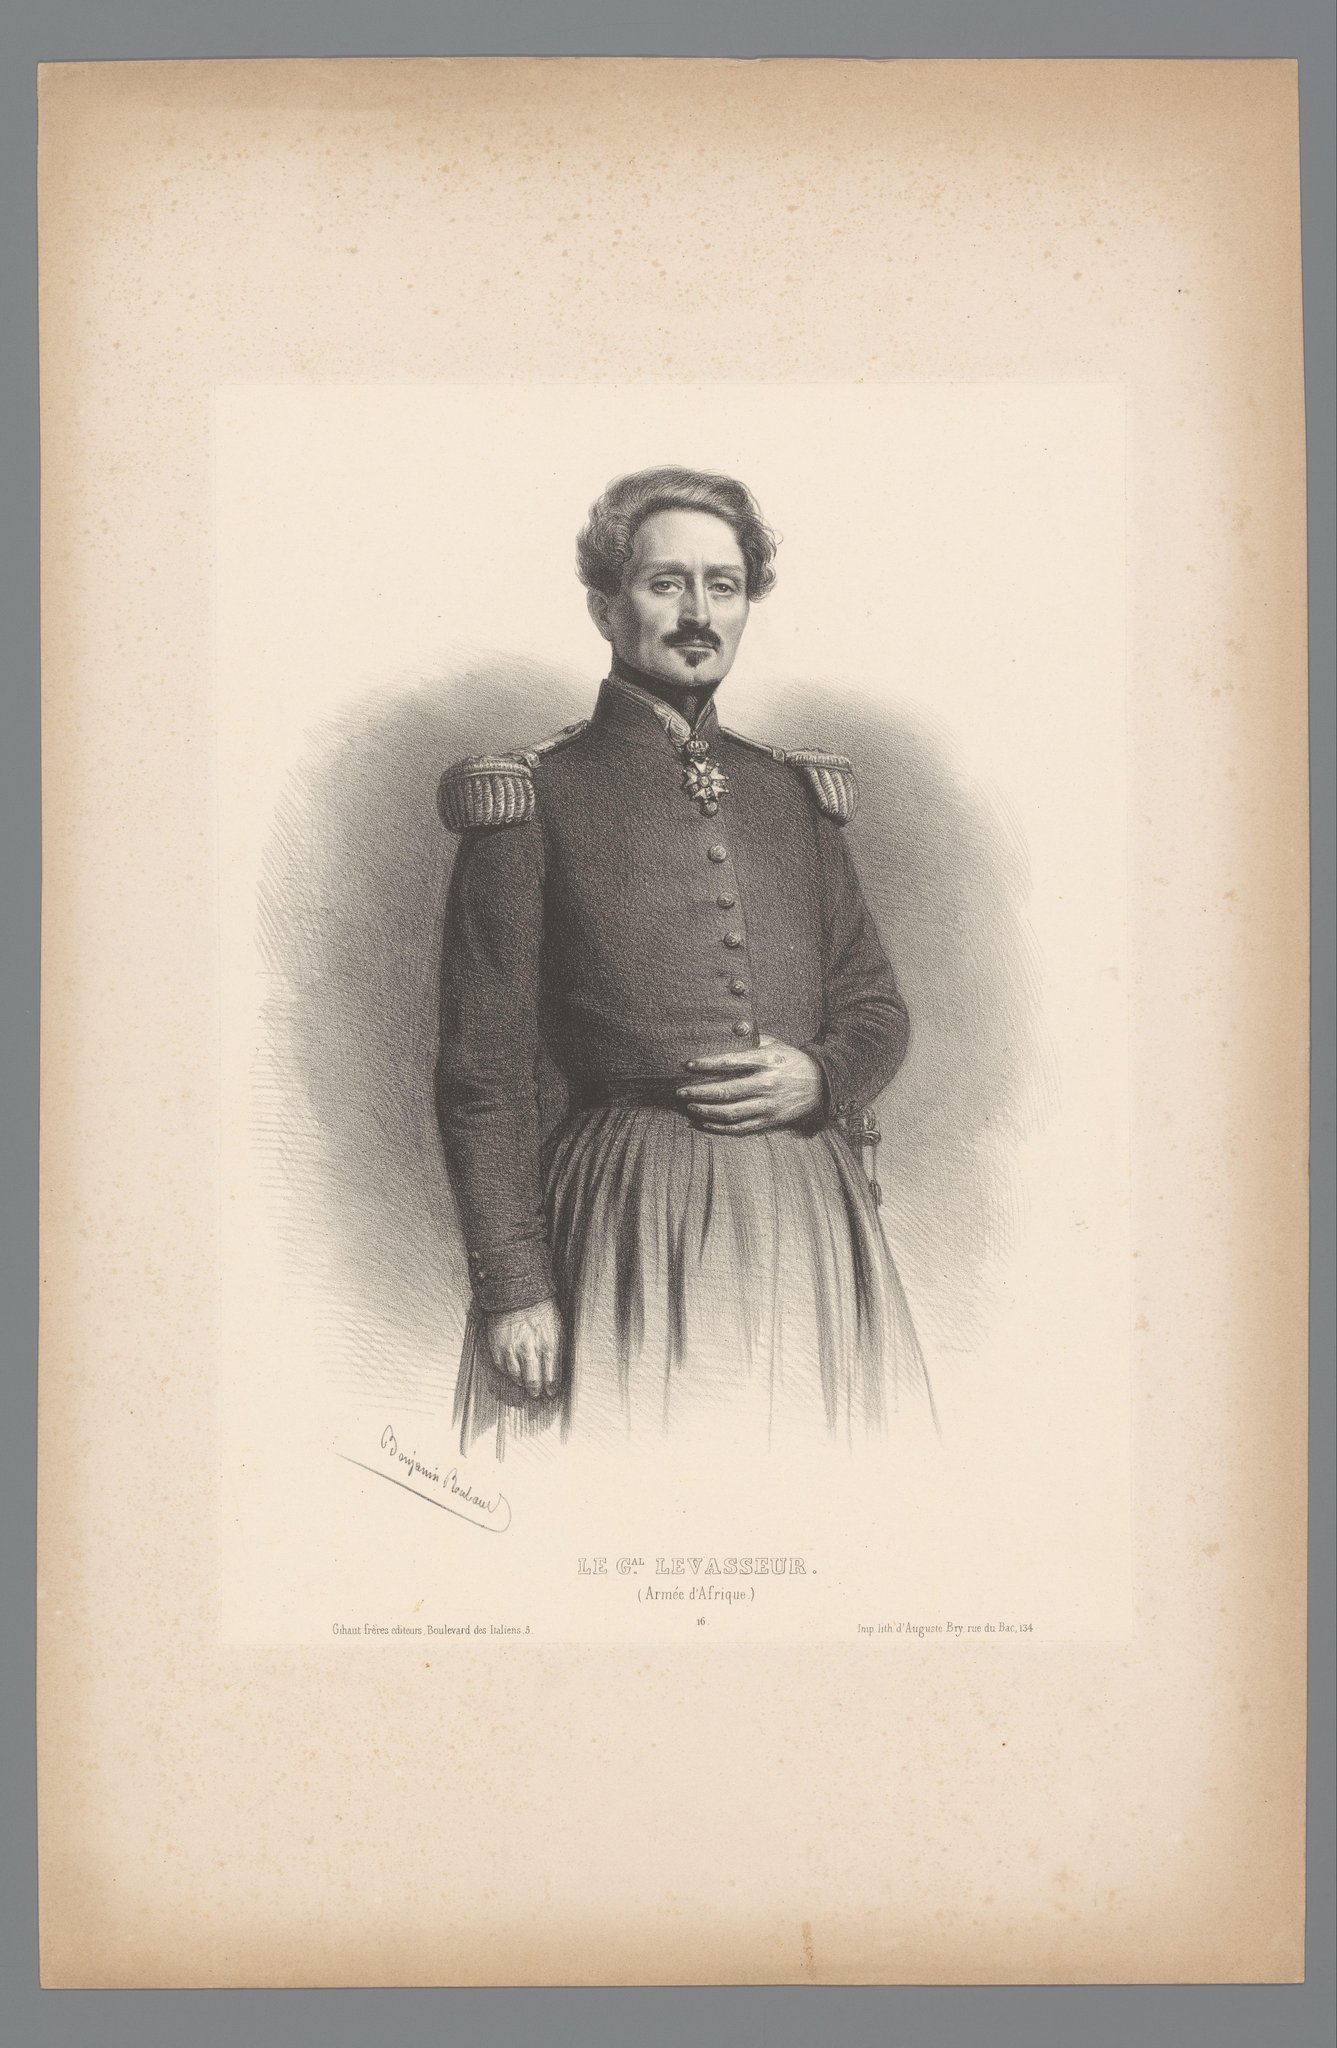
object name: print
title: Souvenirs d'Afrique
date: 1843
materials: paper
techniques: lithograph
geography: paris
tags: paris, politician, commander-in-chief, general, marshal, historical persons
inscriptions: collector's mark: Lugt 2228